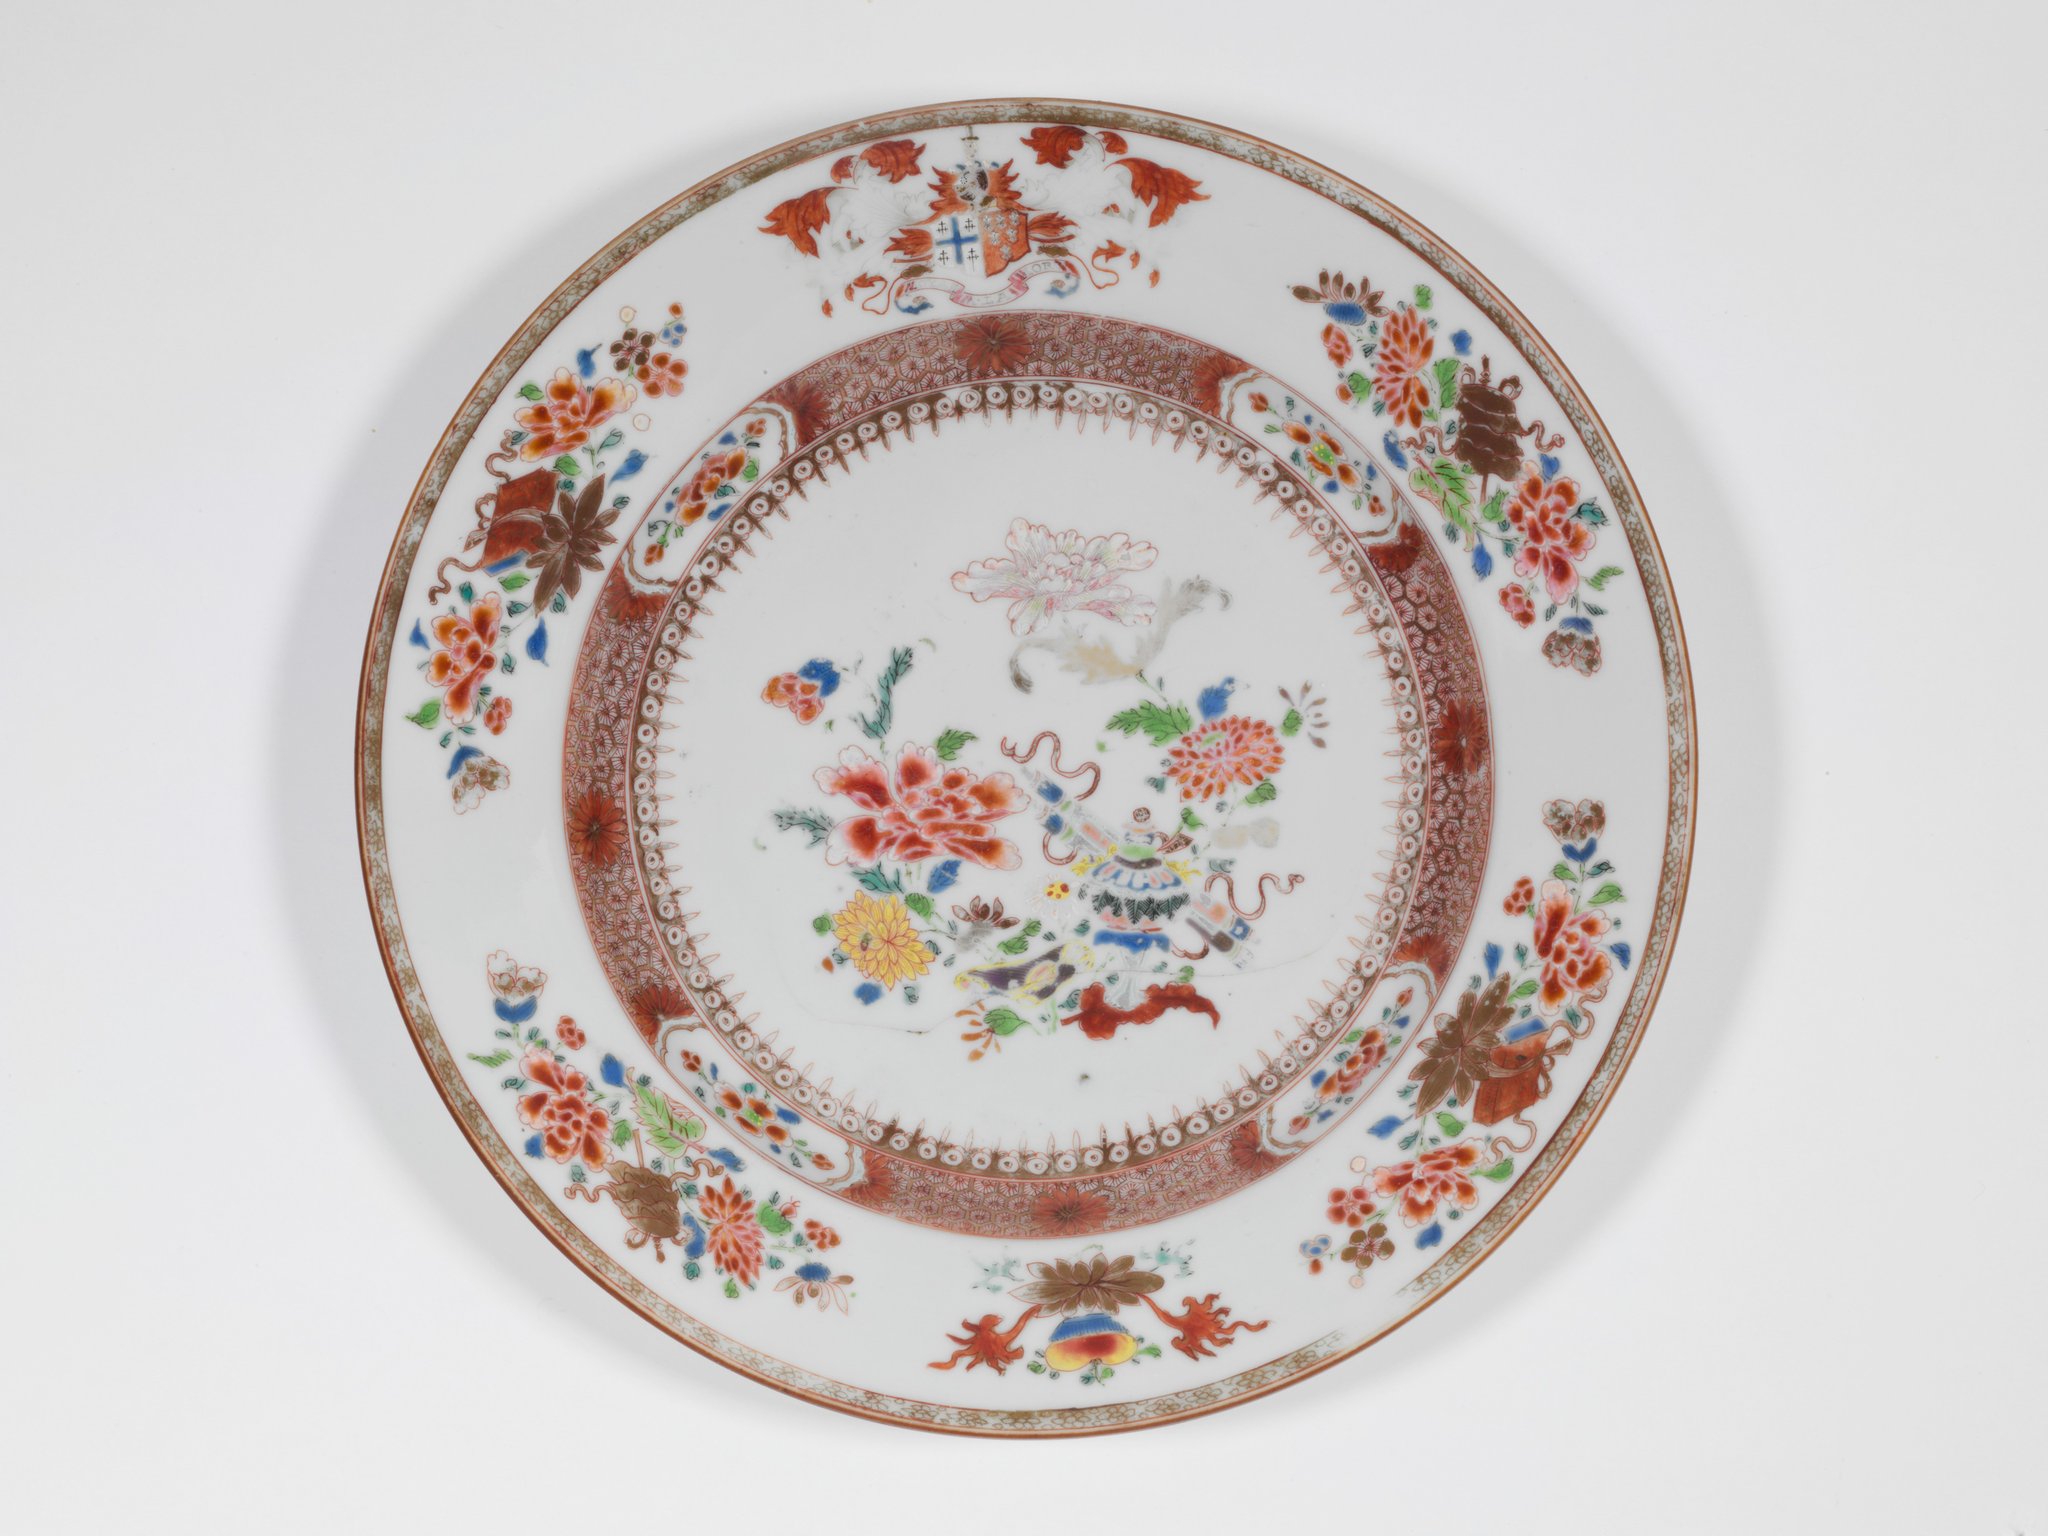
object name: plate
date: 1725-1730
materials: hard paste porcelain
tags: flowers